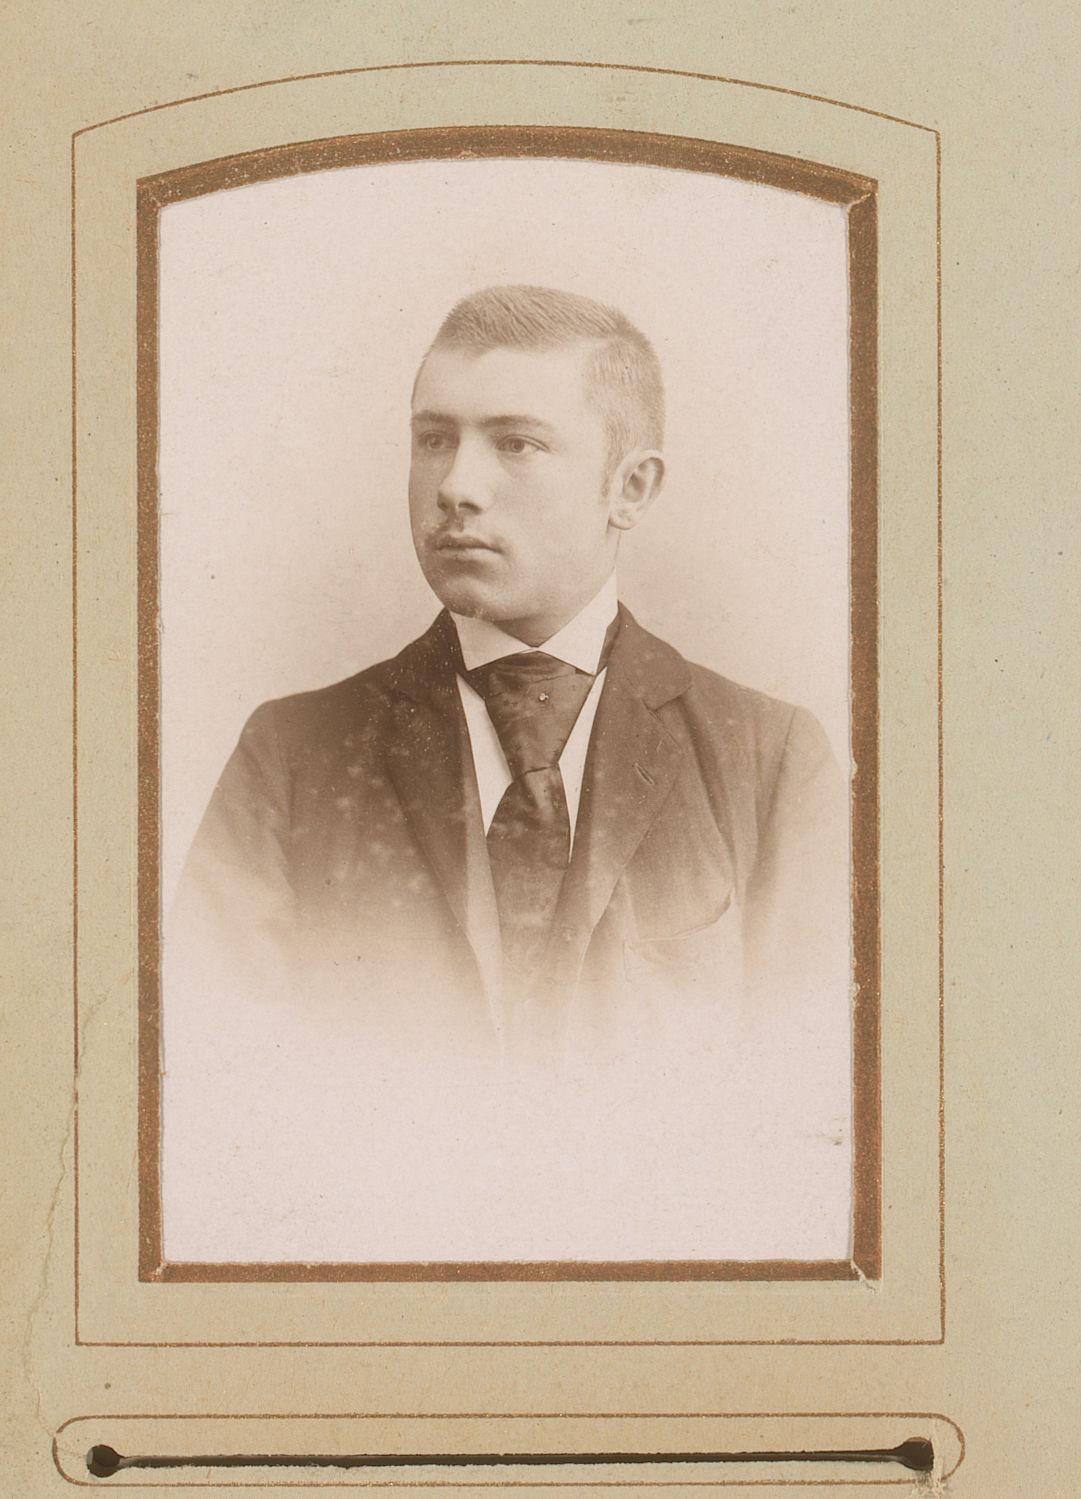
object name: photograph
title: Portret van een jonge man met stropdas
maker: johannes leonardus van der heijden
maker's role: fotograaf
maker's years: 1856-1937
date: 1893-1915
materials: cardboard, photographic support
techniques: collodion silver print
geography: amsterdam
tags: historical persons, youth, adolescent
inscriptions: inscription: ‘Eere Diploma/ UTRECHT 1893/ (...)/ Johs. L. van der Heijden/ Amsterdam/ Sophiaplein MUNT./ Specialiteit in onveranderlijke/ photographien en vergrootingen.’